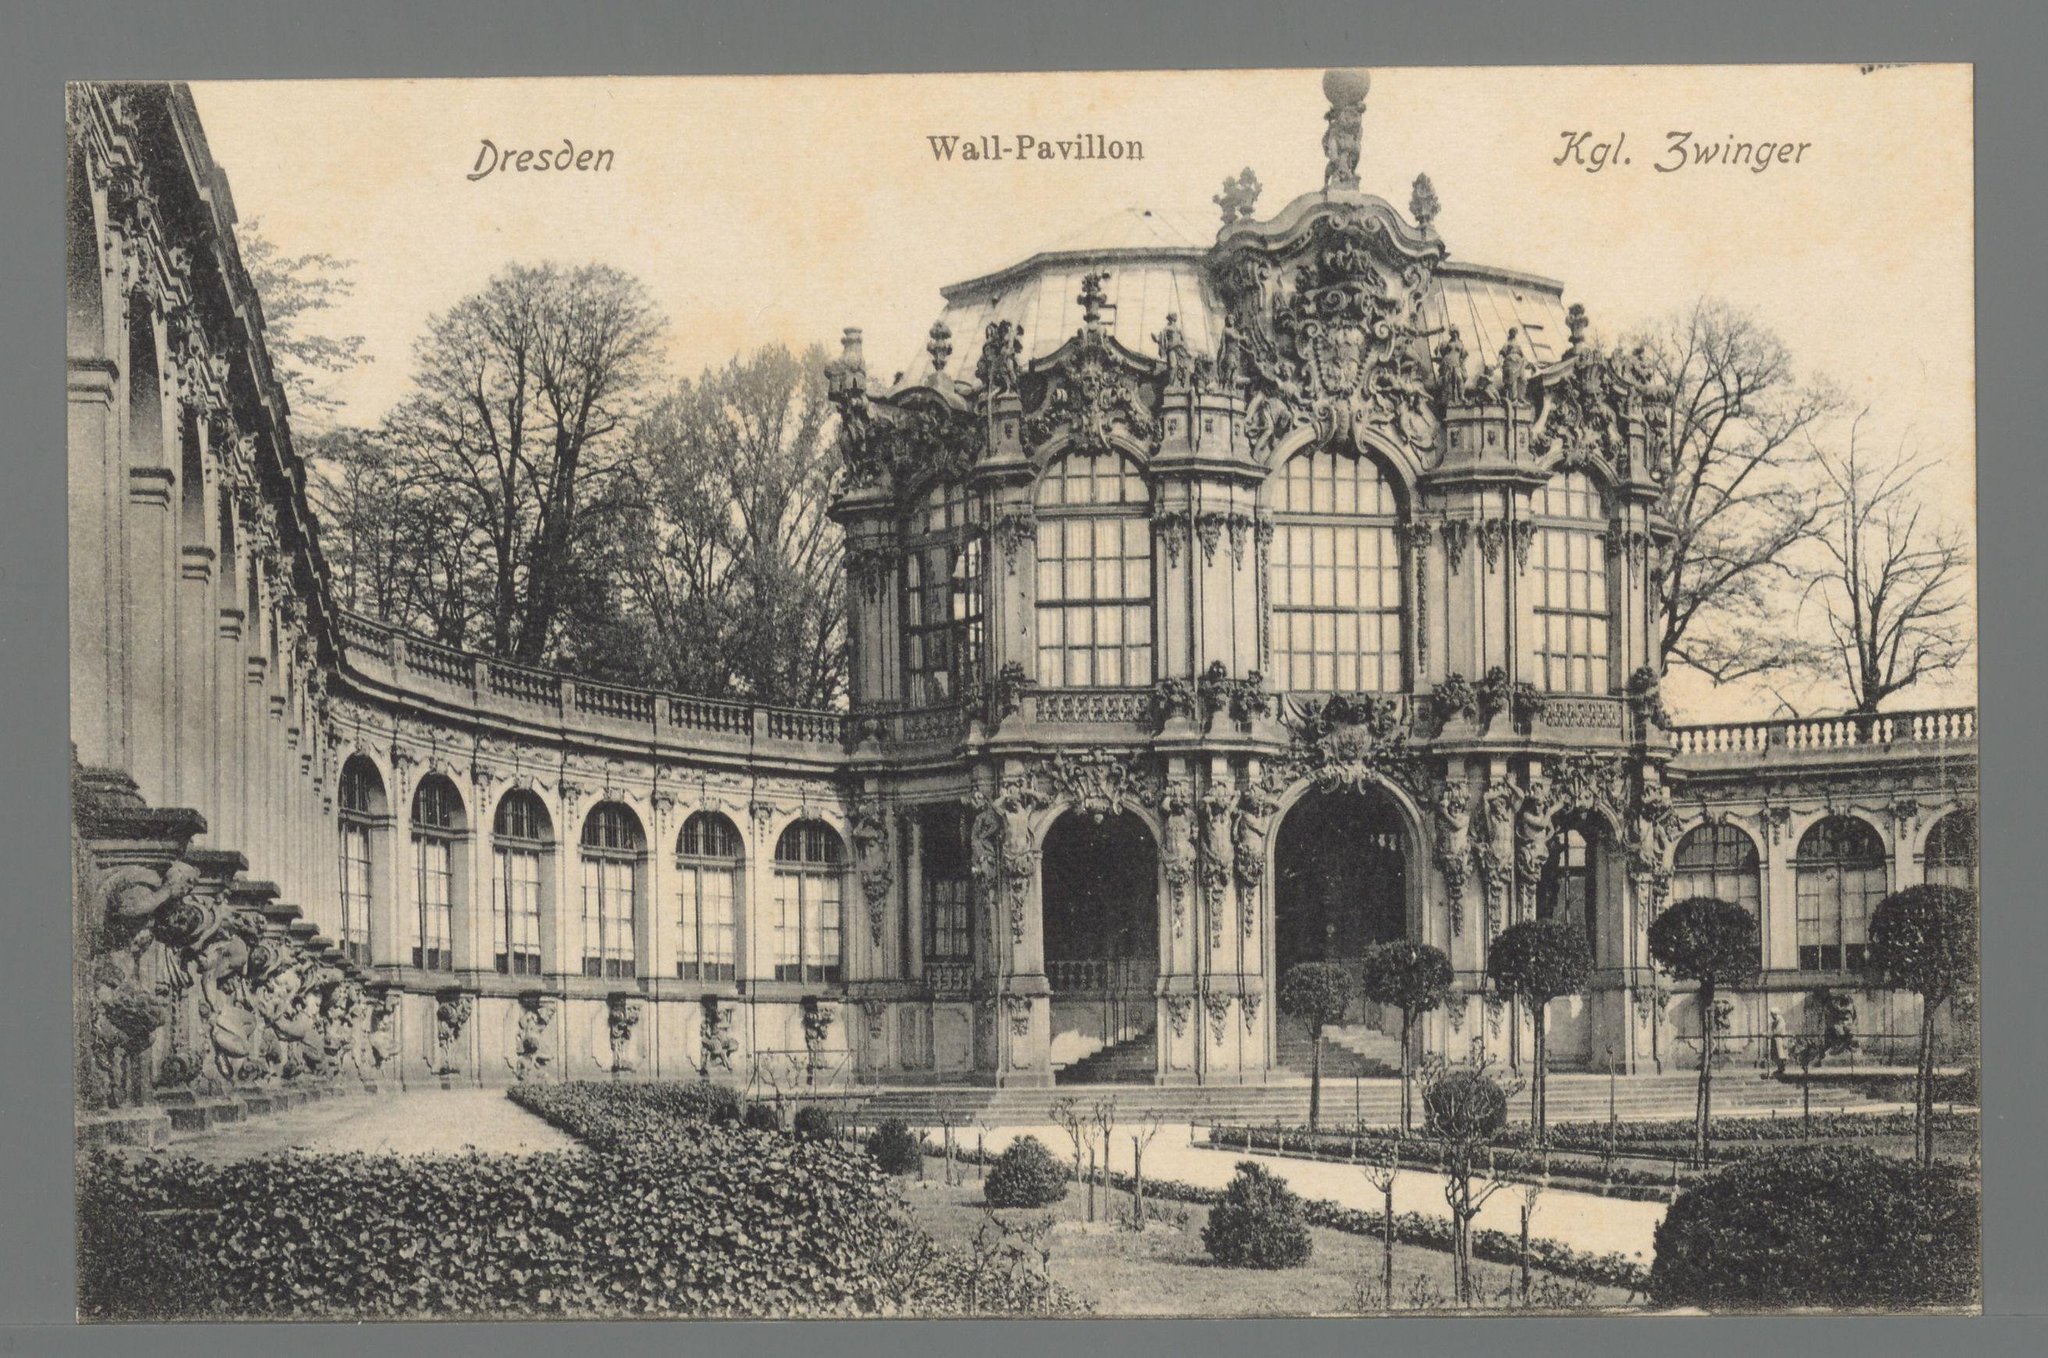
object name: photomechanical print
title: Dresden. Kgl. Zwinger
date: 1905-1930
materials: cardboard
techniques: photograph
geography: dresden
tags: palace